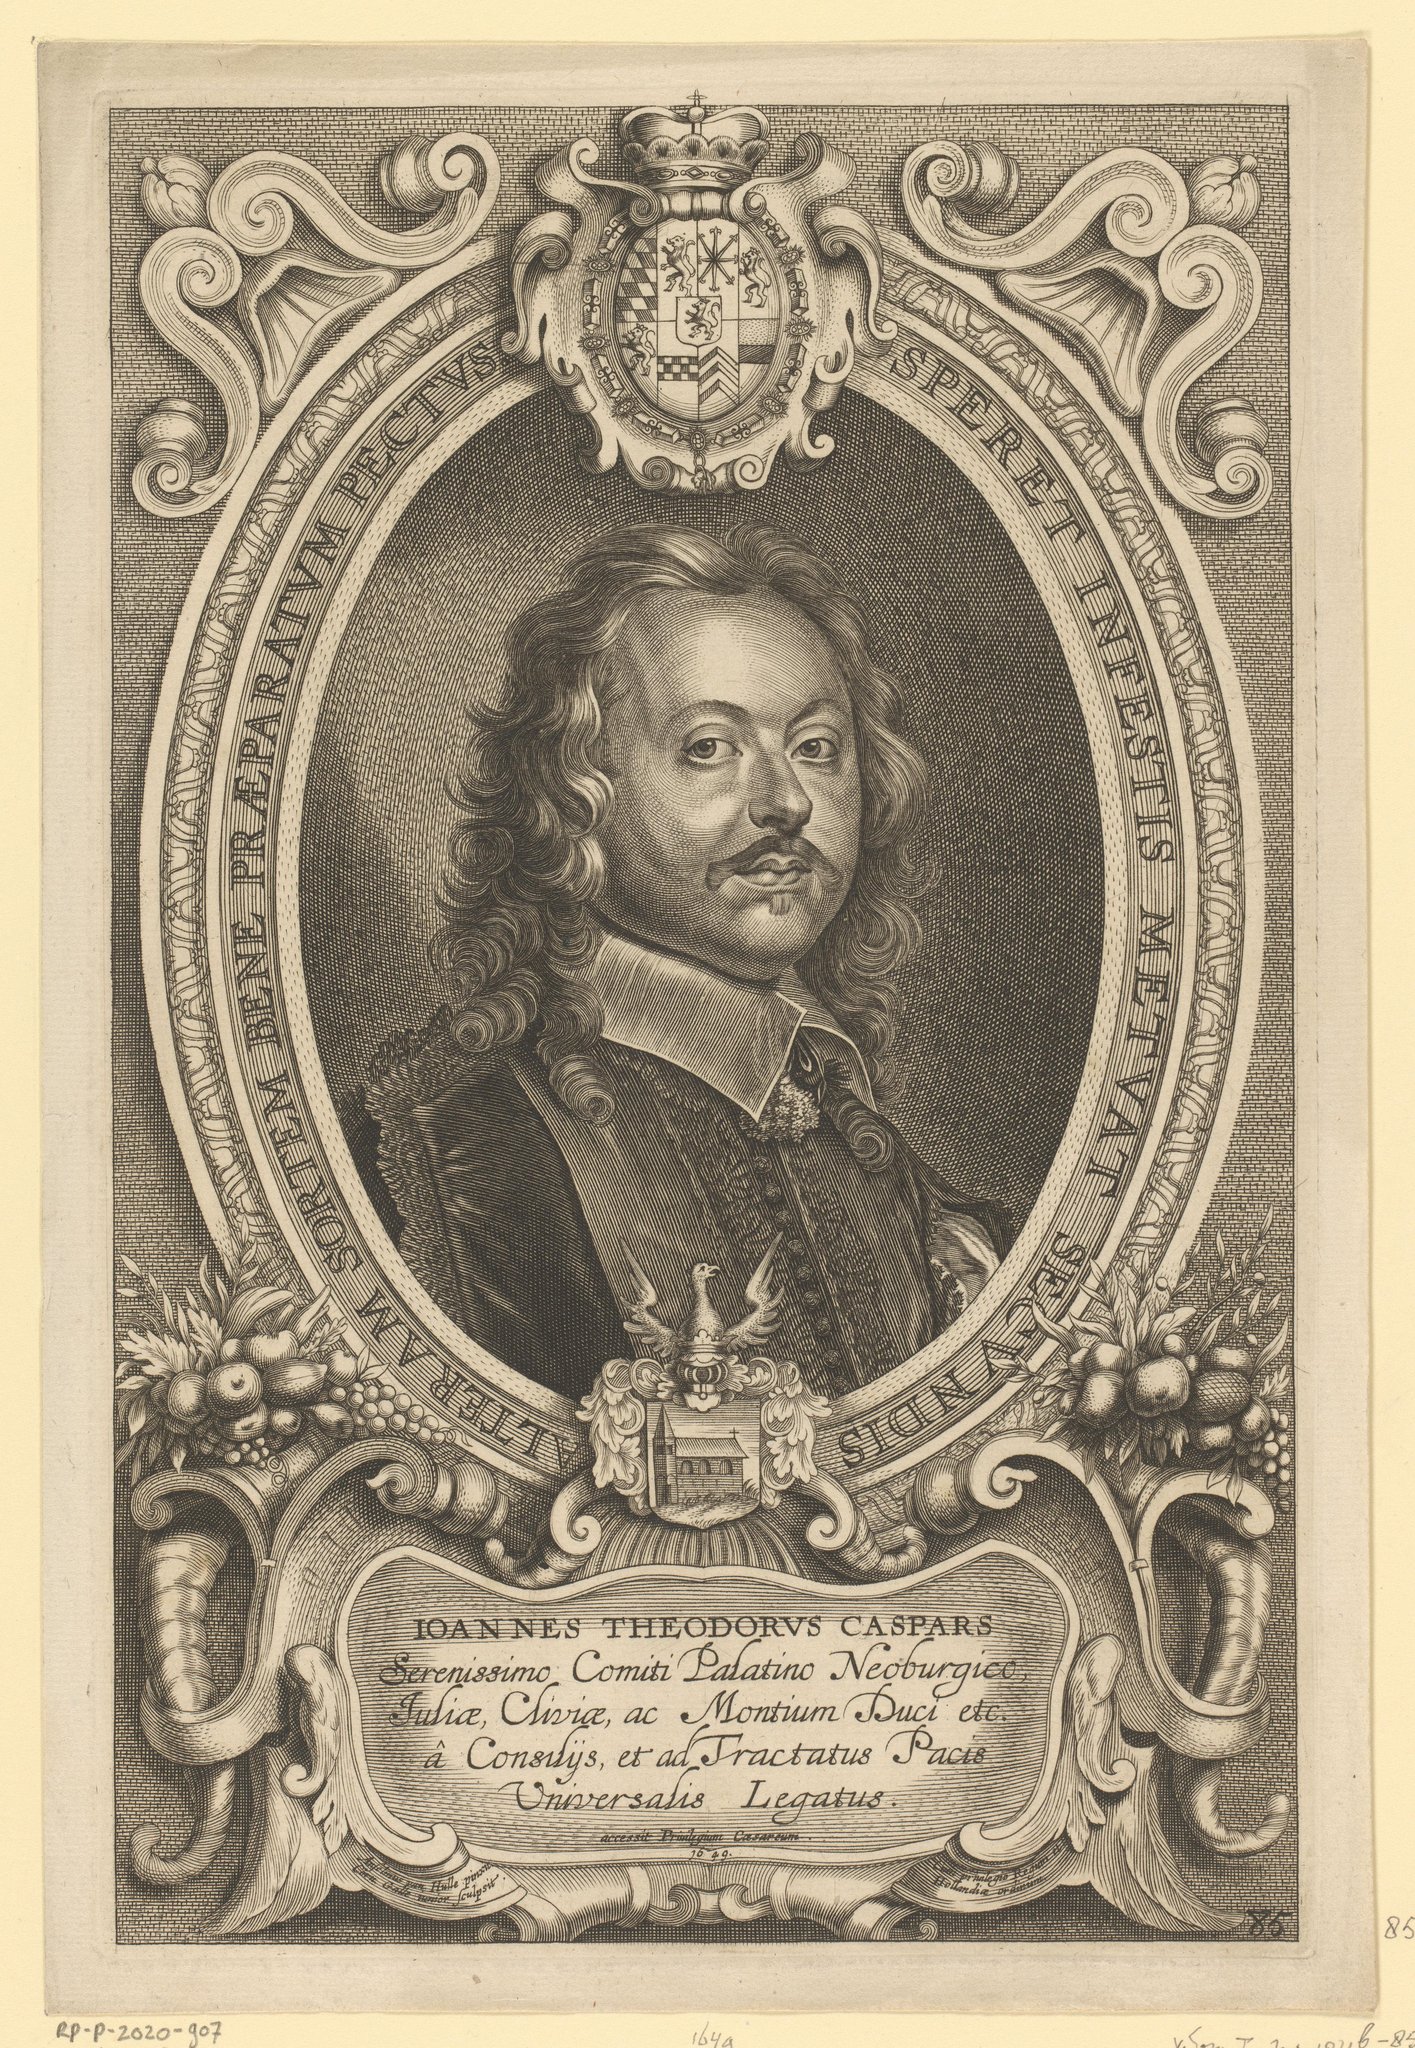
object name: print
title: Portret van Johann Theodor Caspars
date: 1713-1717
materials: paper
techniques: engraving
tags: historical persons, diplomacy, diplomat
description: Prent is gebruikt in verschillende series. De huidige staat is gebruikt in de hieronder vermelde serie en uitgaven (6) en (7). (1)‘Legati Celeberrimi’, uitgegeven door Daniel Middeler in 1648 in Antwerpen. (2)‘Legati Celeberrimi’, waarschijnlijk uitgegeven in 1651, maar opnieuw met de vermelding door Daniel Middeler in 1648 in Antwerpen. (3)‘Legati Celeberrimi', waarschijnlijk uitgegeven in 1658, maar opnieuw met de vermelding door Daniel Middeler in 1648 in Antwerpen. (4) 'Pacificatores orbis Christiani, sive icones principum, ducum et legatorum, qui Monasterii atque Osnabrugae (...)', uitgegeven door Pieter van der Slaart in 1696 in Rotterdam. (5) 'Pacificatores orbis Christiani, sive icones principum, ducum et legatorum, qui Monasterii atque Osnabrugae (...)', uitgegeven door Pieter van der Slaart in 1697 in Rotterdam. (6) 'Pacificatores orbis Christiani, sive icones principum, ducum et legatorum, qui Monasterii atque Osnabrugae (...)', waarschijnlijk uitgegeven circa 1713, maar opnieuw met vermelding van Pieter van der Slaart in 1697 in Rotterdam. De platen in deze uitgave zijn voor het eerst genummerd. (7) 'Les hommes illustres qui ont vécu dans le XXIIe siècle (...)', uitgegeven door David Mortier in 1717 in Rotterdam. Zie documentatie. Mogelijk zijn er nog meerdere uitgaven en staten van deze prent.